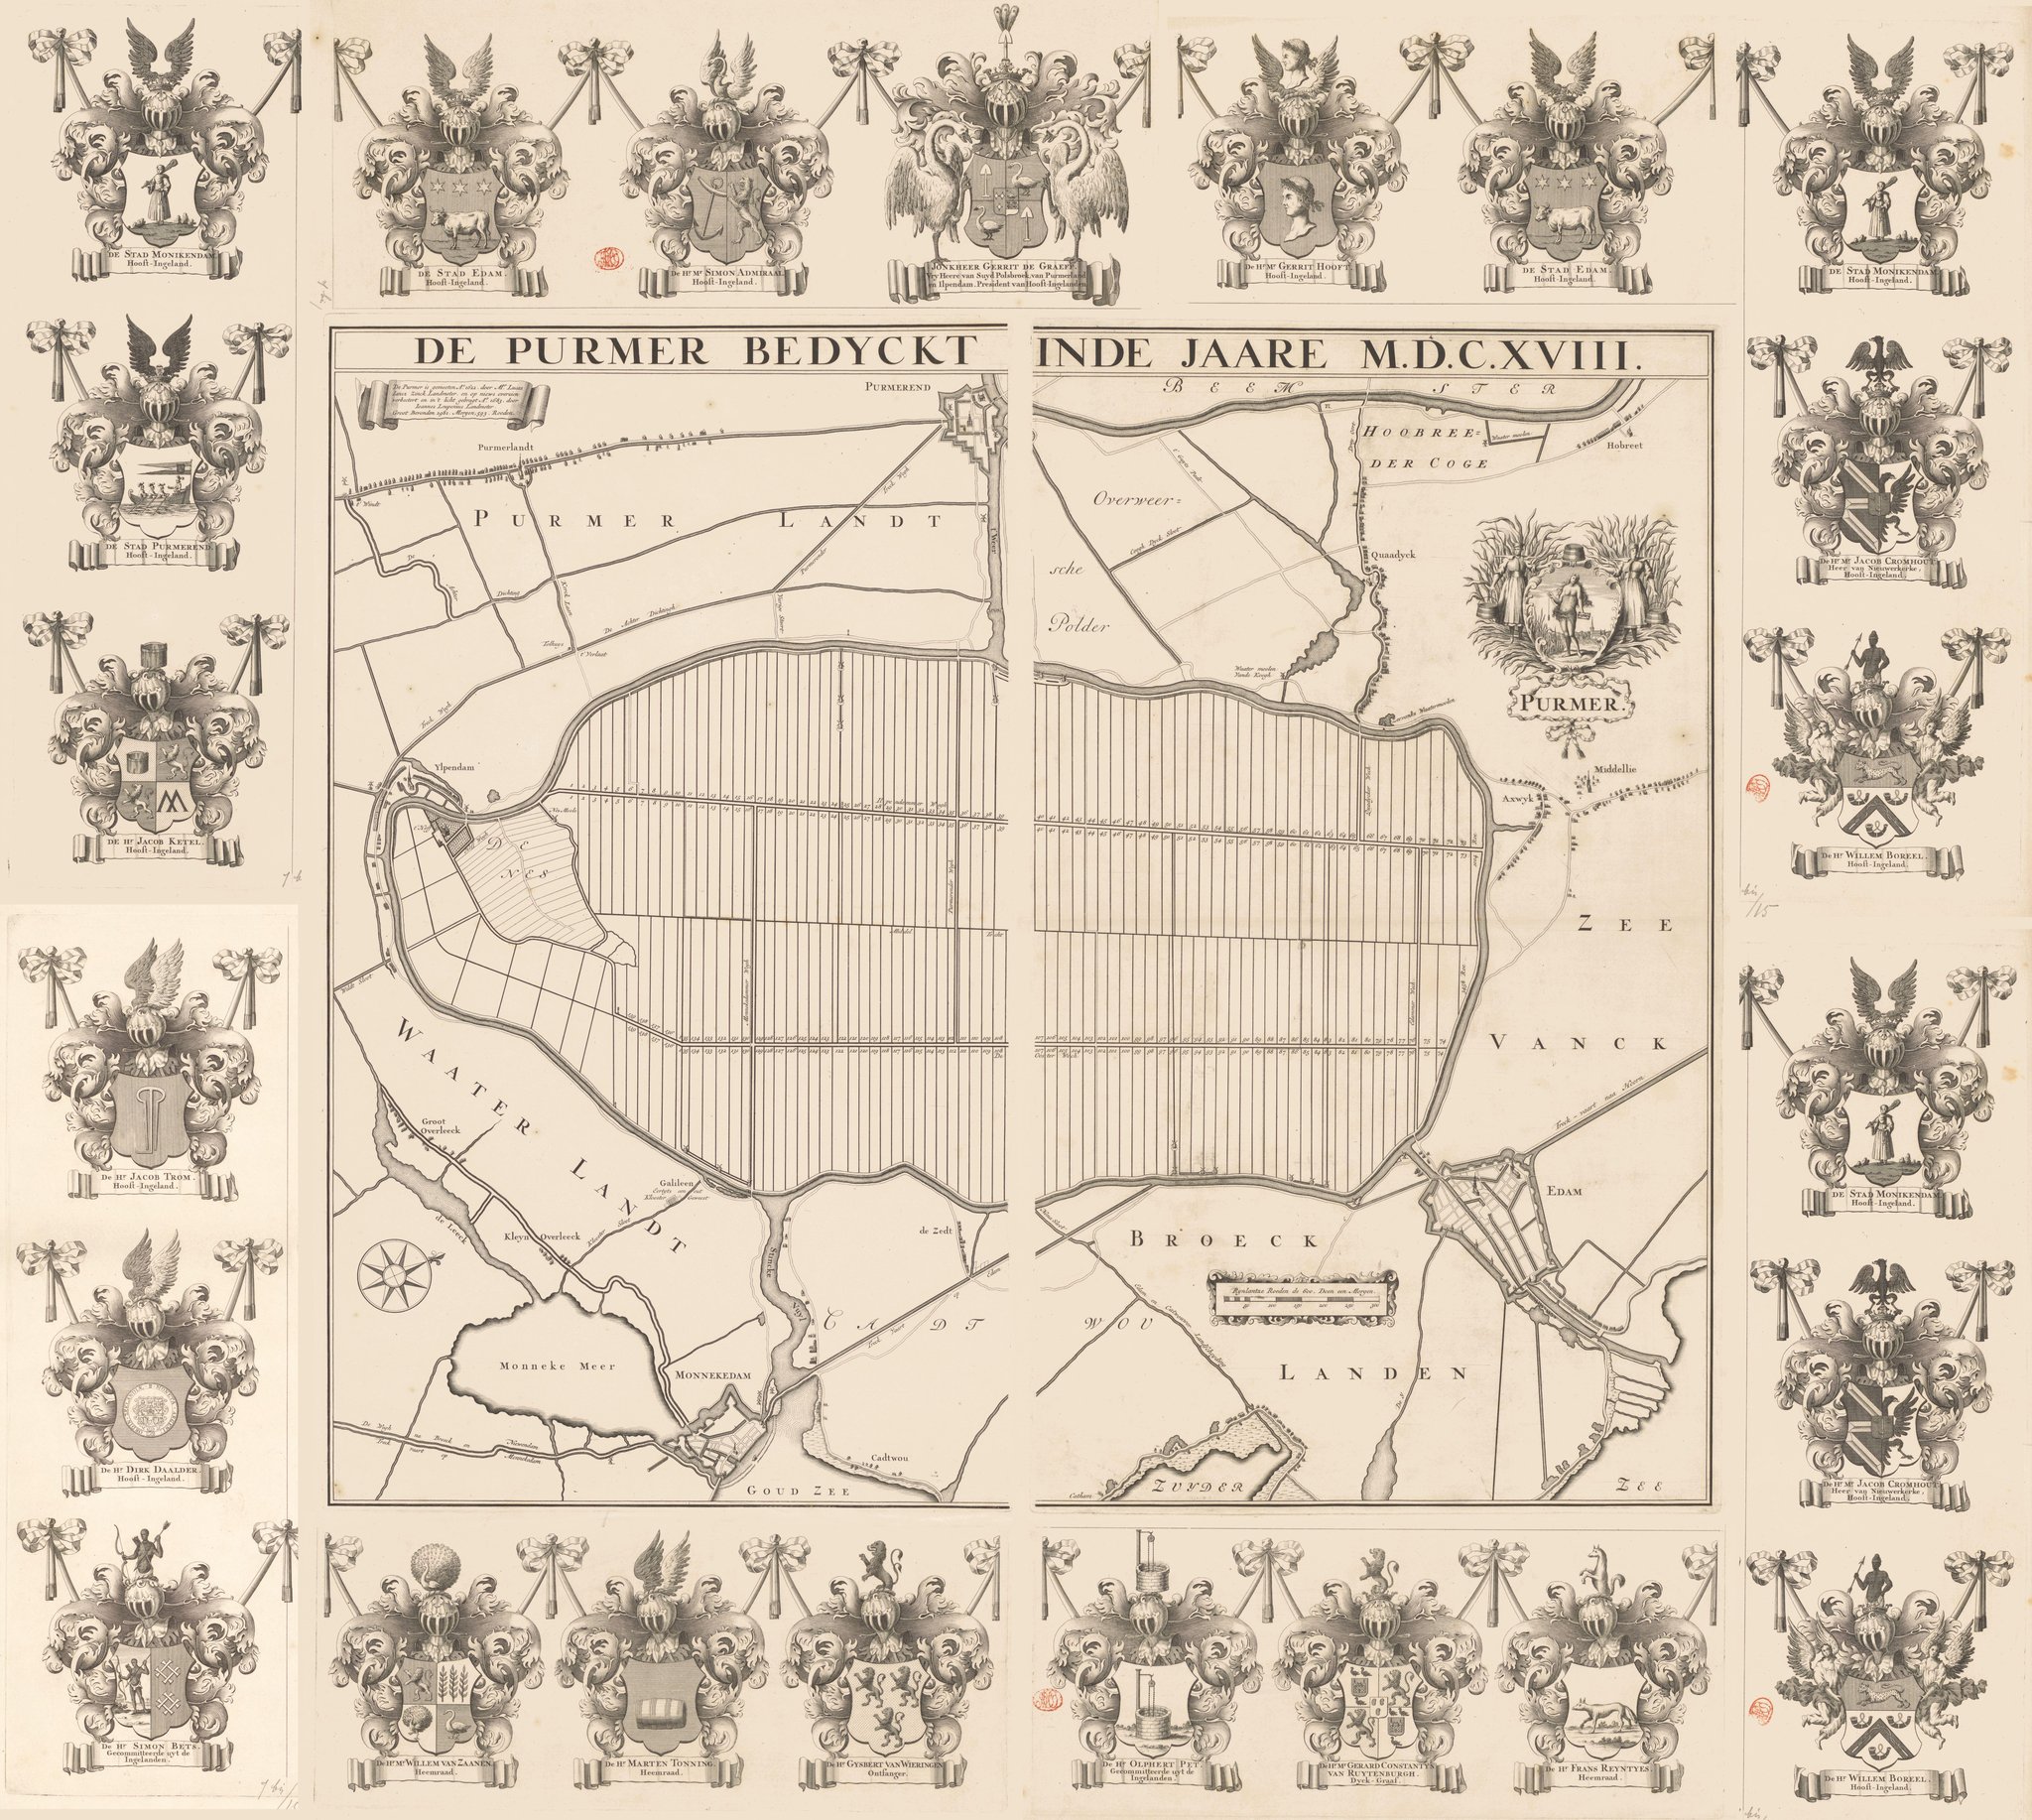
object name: map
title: Kaart van de Purmer met wapenrand, bestaande uit zes delen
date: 1683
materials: paper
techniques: engraving, etching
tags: coat of arms (as symbol of the state, etc.), maps of separate countries or regions, polder, reclaimed land, armorial bearing, heraldry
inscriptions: collector's mark: Lugt 195, collector's mark: Lugt 195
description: Op de kaart rechtsboven het wapen van de Purmer, rechtsonder een schaalstok: Rynlantze roeden de 600. doen een morgen. Om de kaart heen een wapenrand met de wapens van de dijkgraaf, heemraden, secretaris, ontvanger, hoofdingelanden en gecommitteerden van de ingelanden.